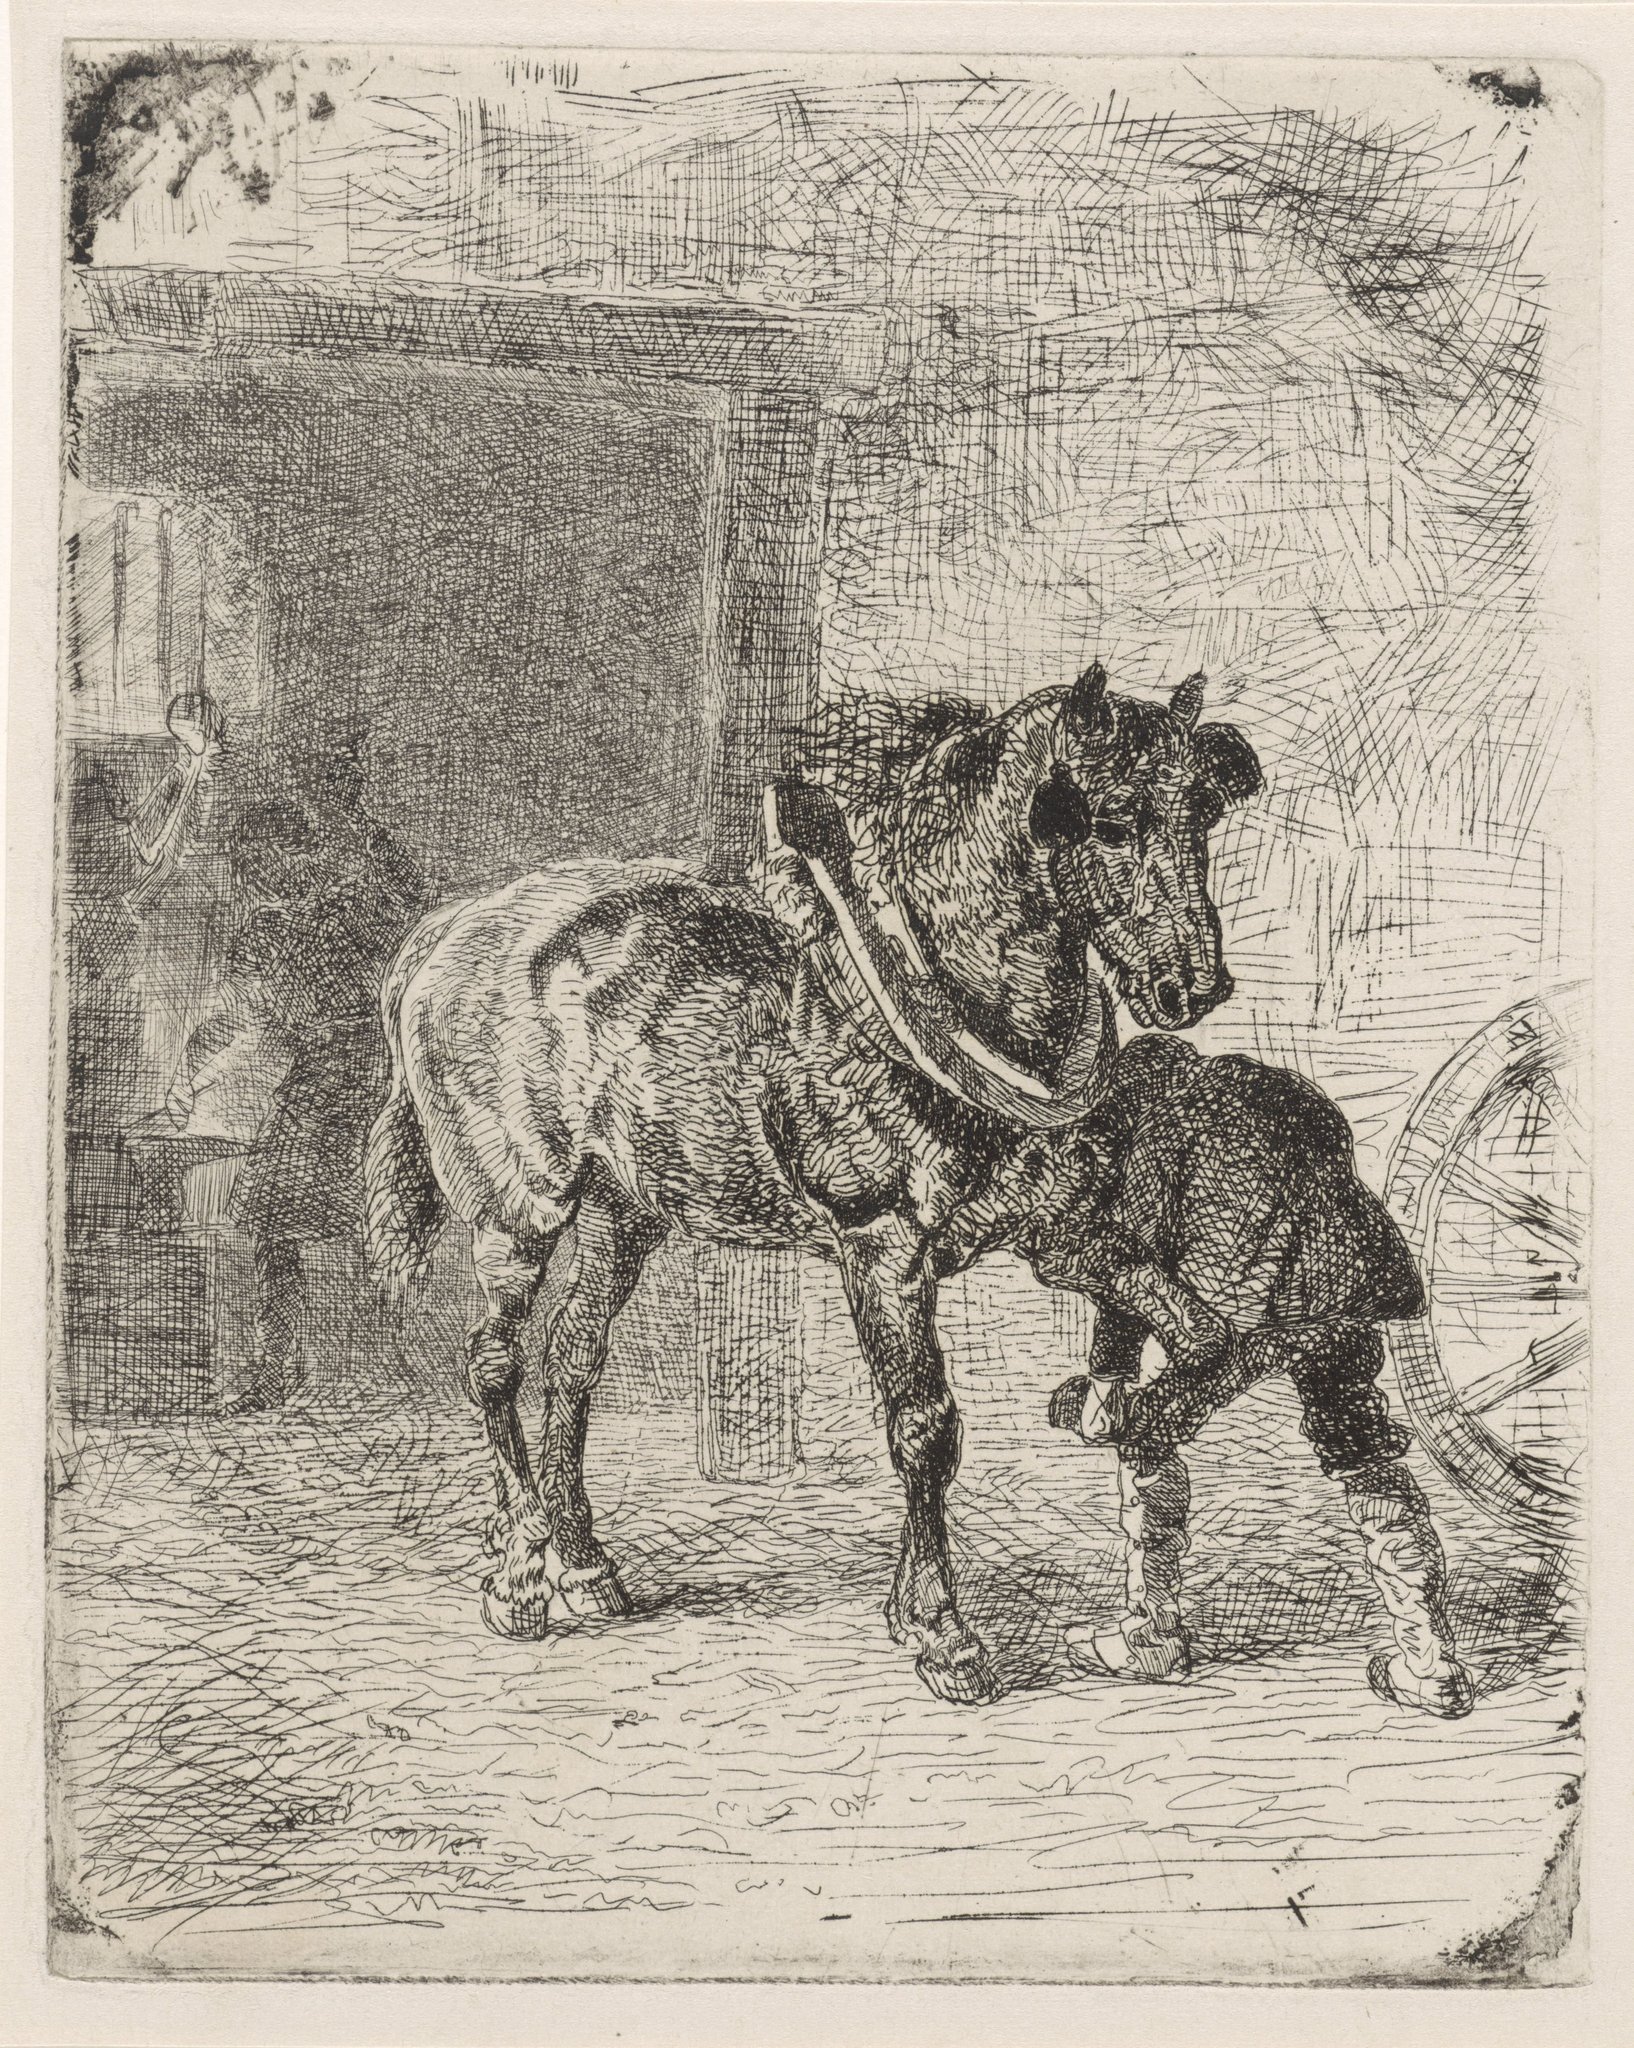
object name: print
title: Paard krijgt hoefijzers in een smederij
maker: cornelis albertus johannes schermer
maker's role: draughtsman, painter, print maker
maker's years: 1824-1915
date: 1839-1915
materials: paper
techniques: etching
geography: the hague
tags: farrier, shoeing-smith, horse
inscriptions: collector's mark: Lugt 2228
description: Vooraan beslaat een man de hoef van een paard. Achter hem is een smid in een smederij aan het werk bij een aambeeld.